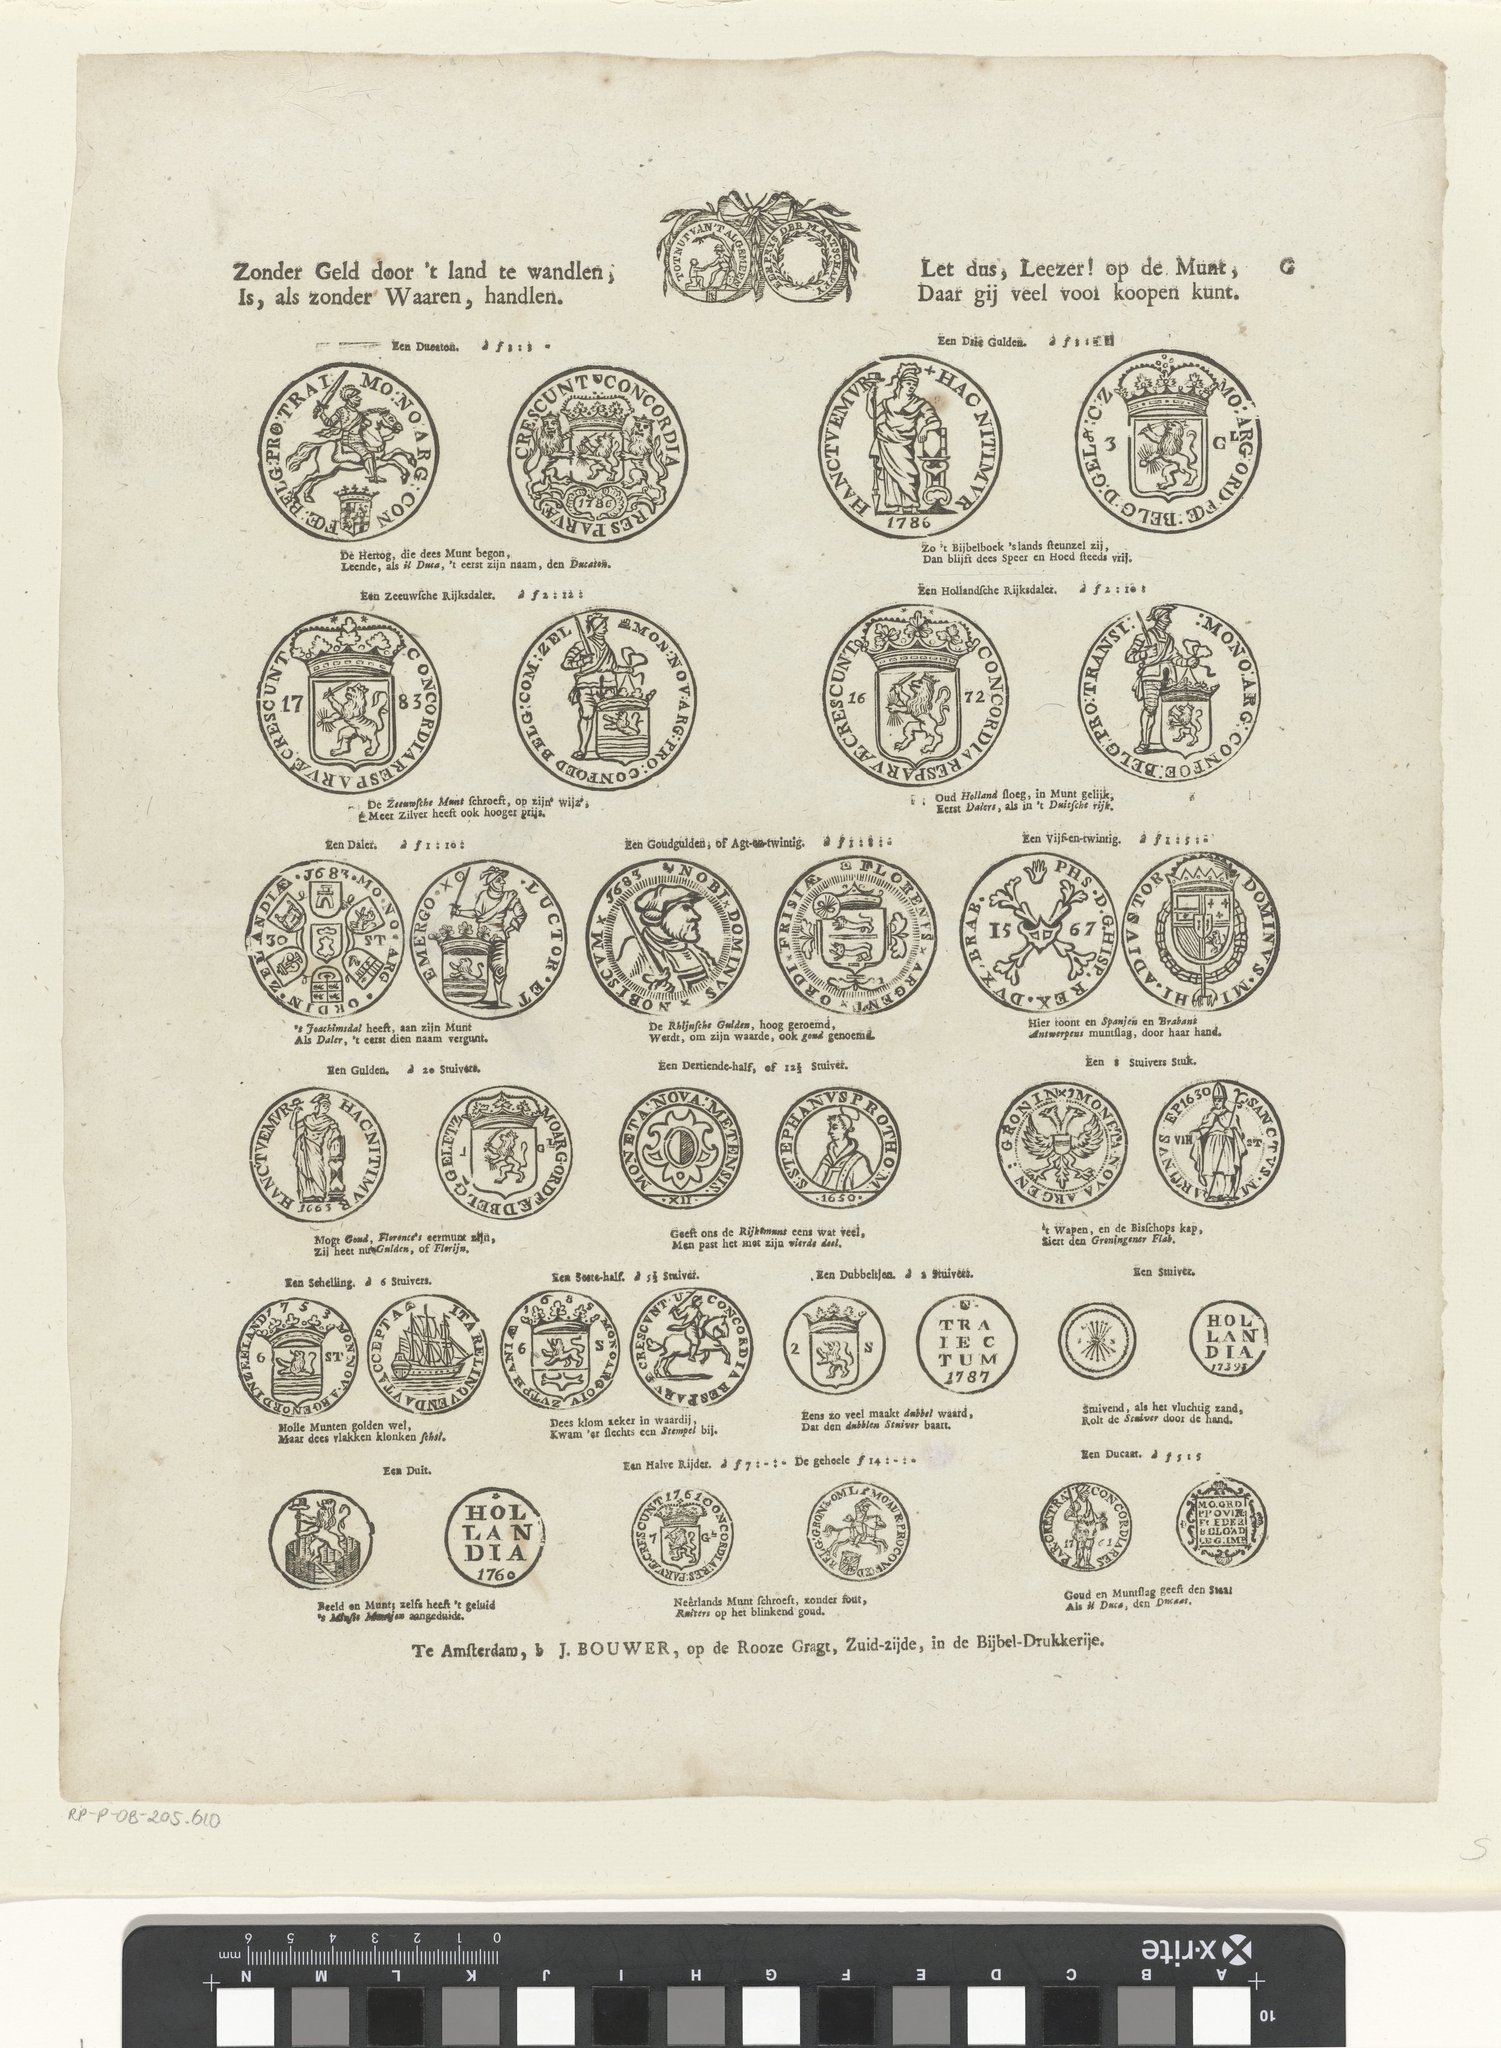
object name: print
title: Zonder geld door 't land te wandlen, / Is als zonder waaren, handlen. / Let dus, leezer! op de munt, / Daar gij veel voor koopen kunt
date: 1805-1808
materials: paper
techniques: letterpress printing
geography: amsterdam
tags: coin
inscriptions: collector's mark: Lugt 2760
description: Blad met 17 voorstellingen van oude Nederlandse munten, voor- en keerzijde. Boven elke voorstelling de naam en waarde van de munt, eronder een tweeregelig vers. Midden boven het zegel van de Maatschappij tot Nut van 't Algemeen. Genummerd rechtsboven: G.